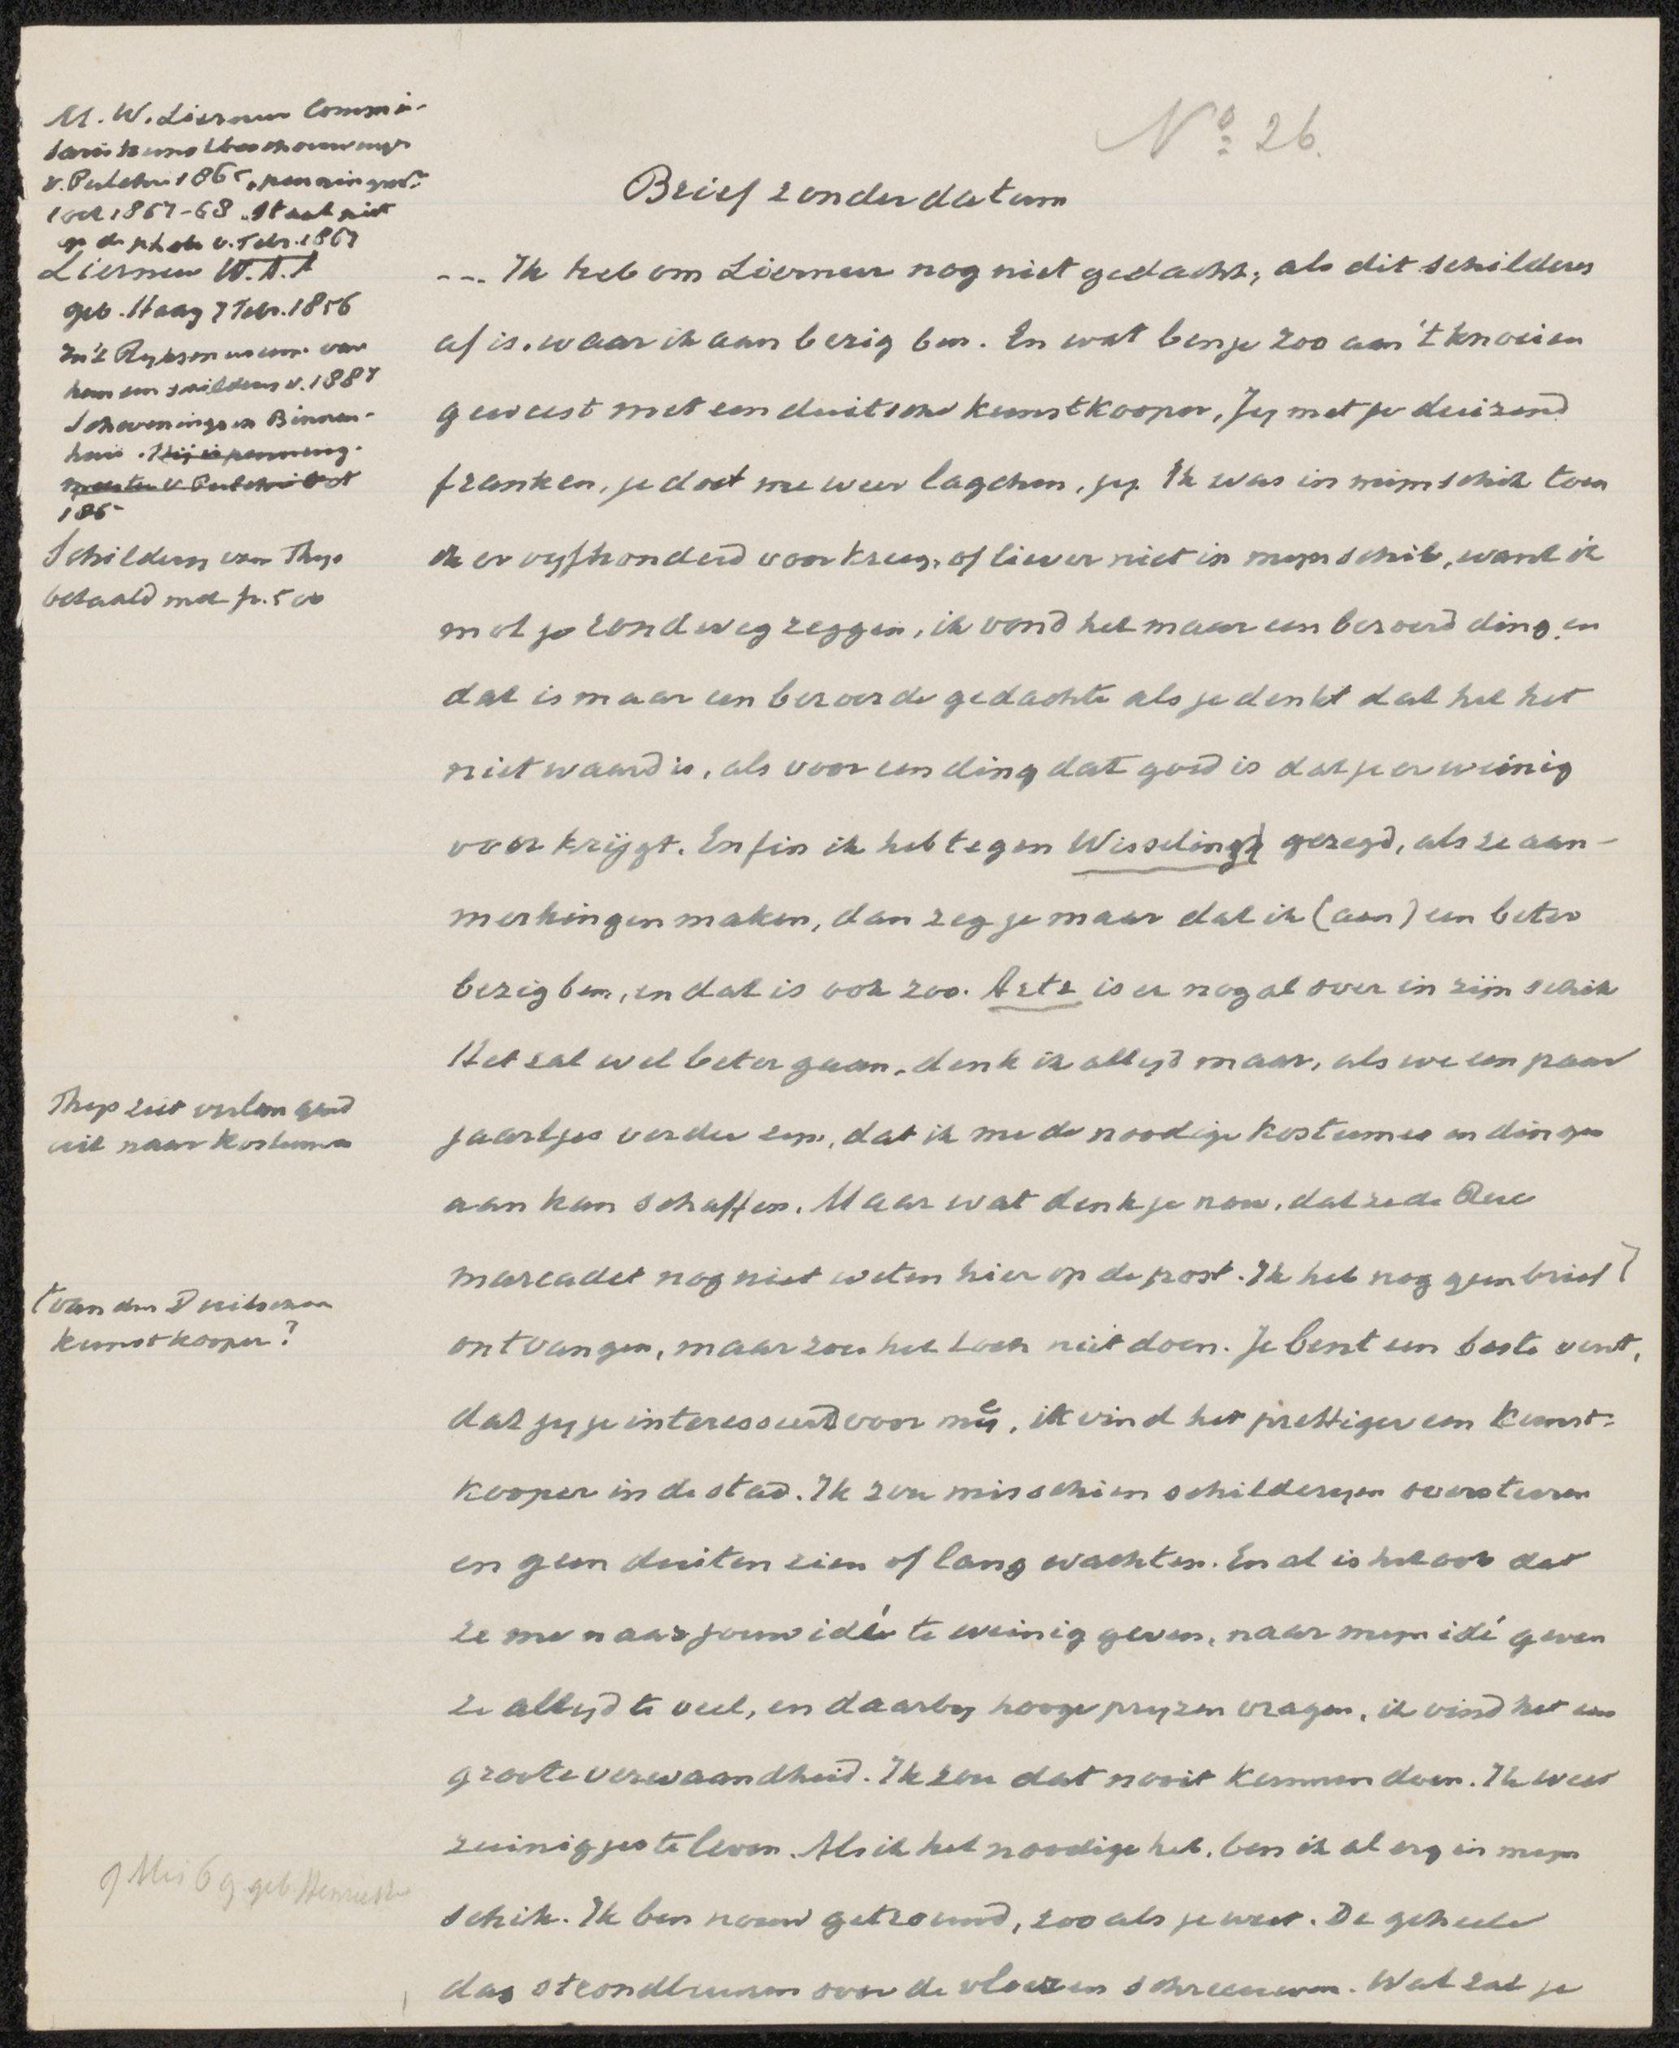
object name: letter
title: Geannoteerde transcriptie van (een deel van) een brief aan Fridolin Becker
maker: pieter haverkorn van rijsewijk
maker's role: museumdirecteur, publicist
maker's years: 1839-1919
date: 1849-1915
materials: ink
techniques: pen, writing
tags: the hague, print maker, fridolin becker, martinus wilhelmus liernur, draughtsman, david adolph constant artz, elbert jan van wisselingh, art trade, art shop, painting (including book-illumination, miniature-painting), paris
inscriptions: collector's mark: Lugt 2233